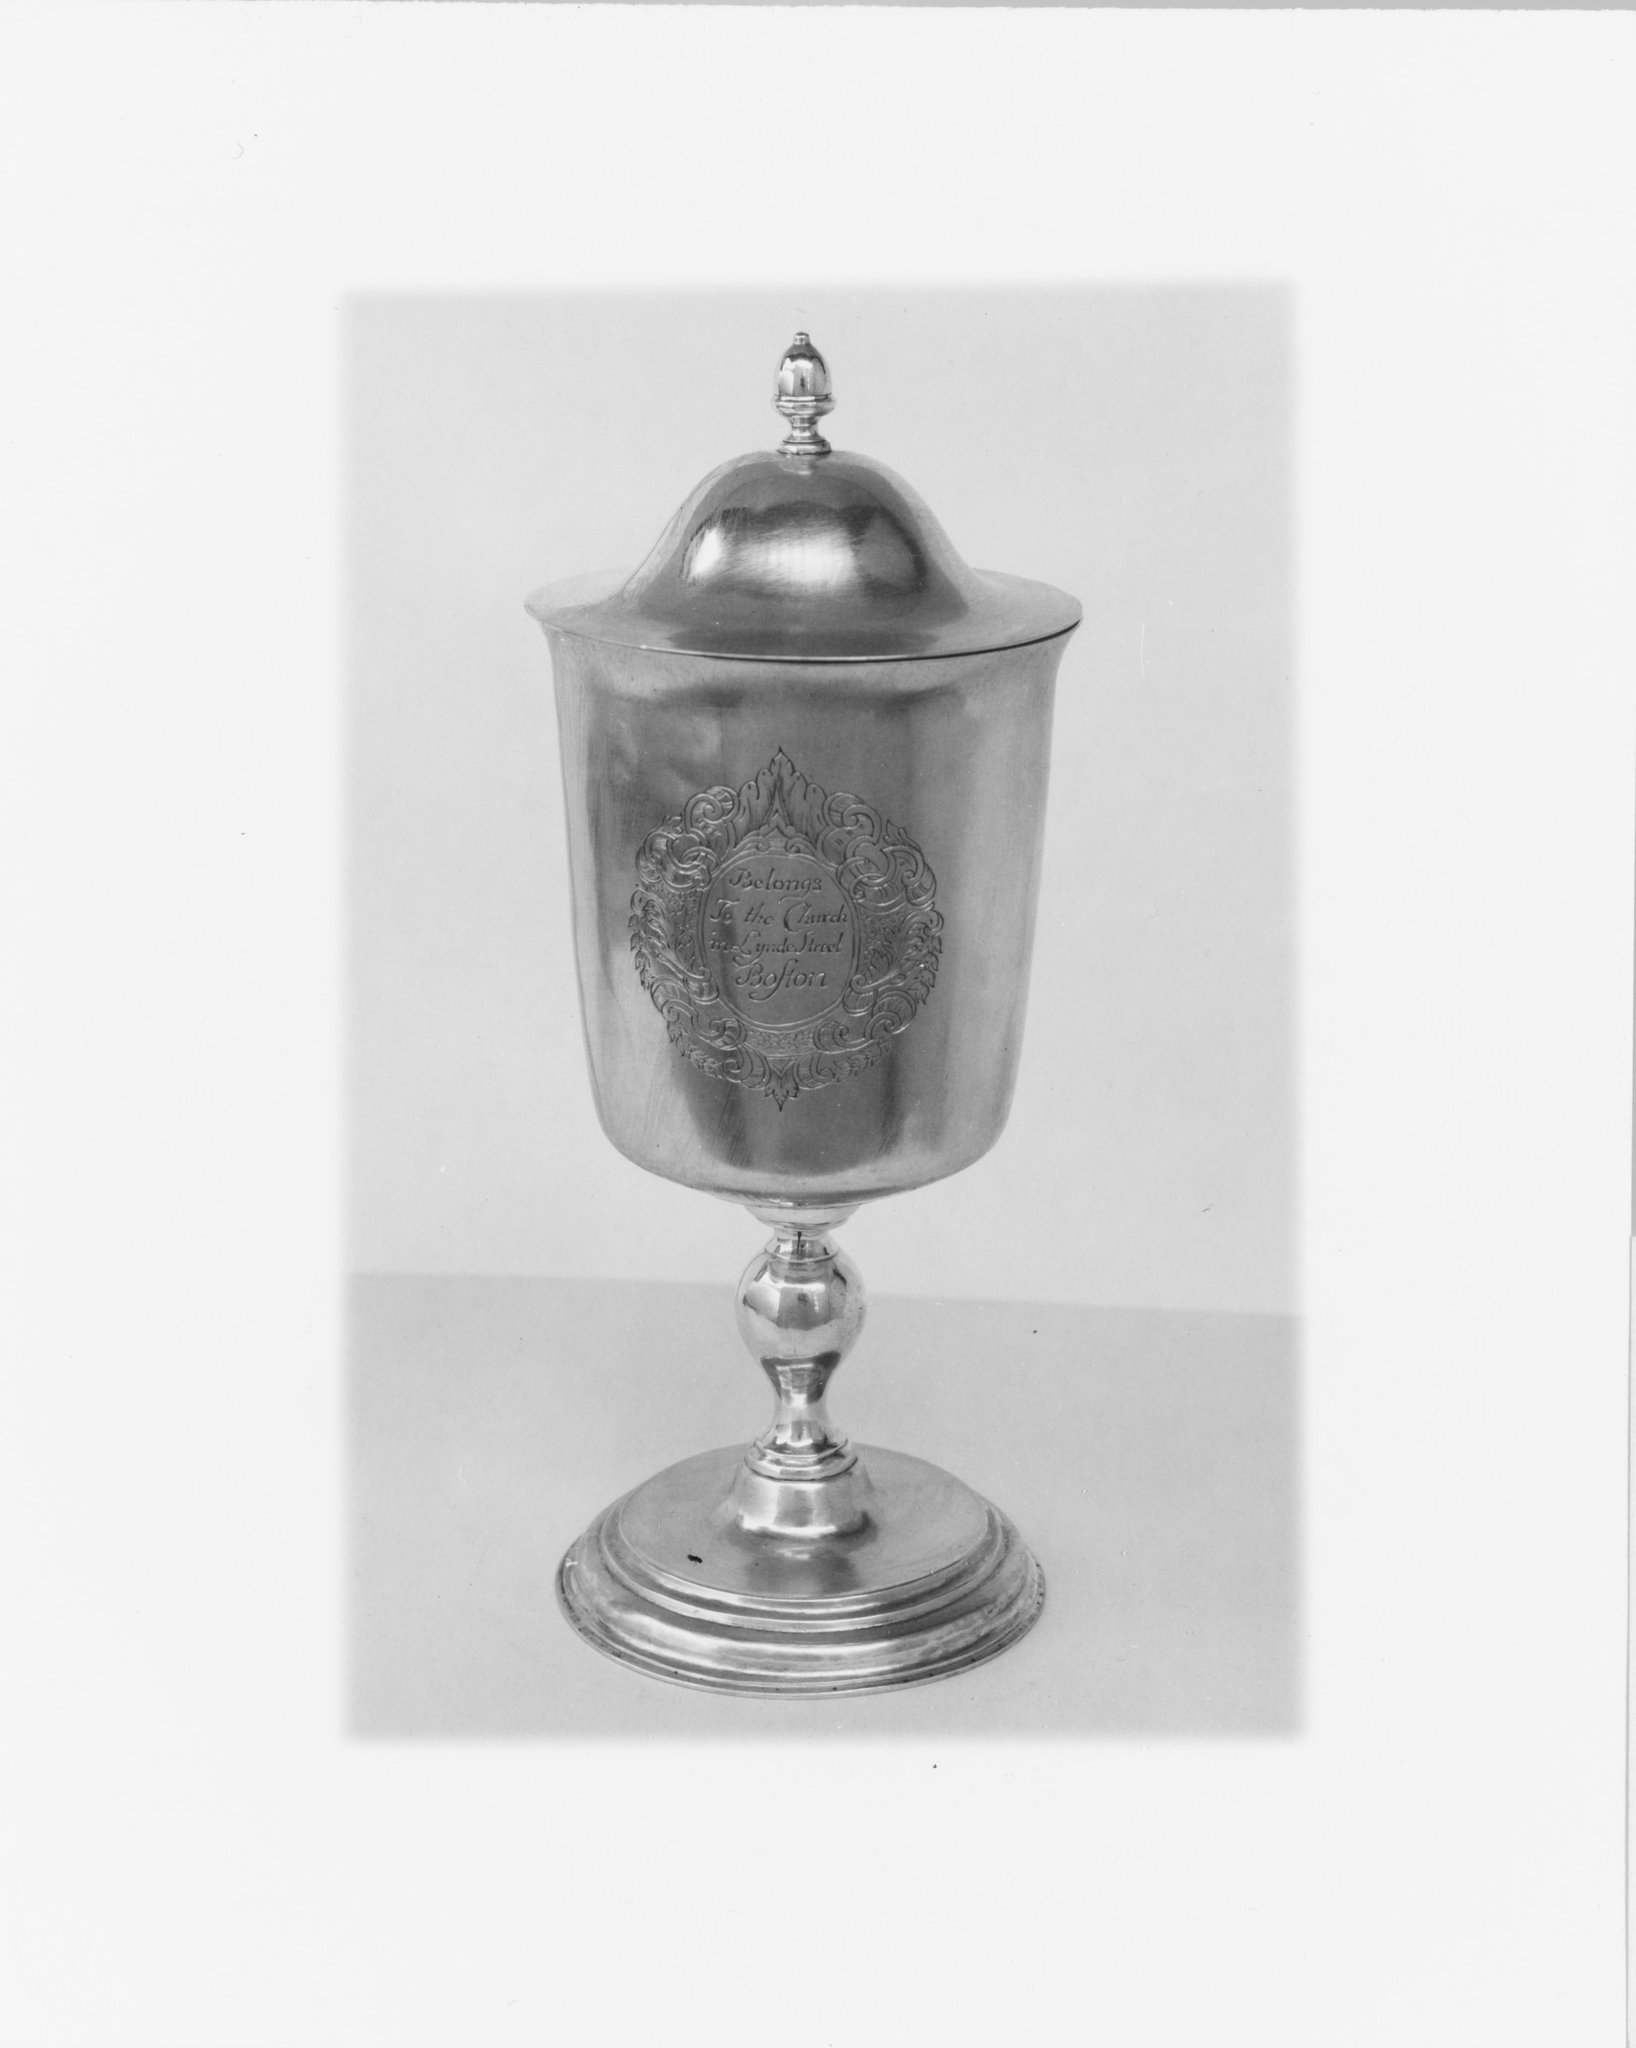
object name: cup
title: Cover for Wine Cup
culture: american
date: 1740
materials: silver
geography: united states